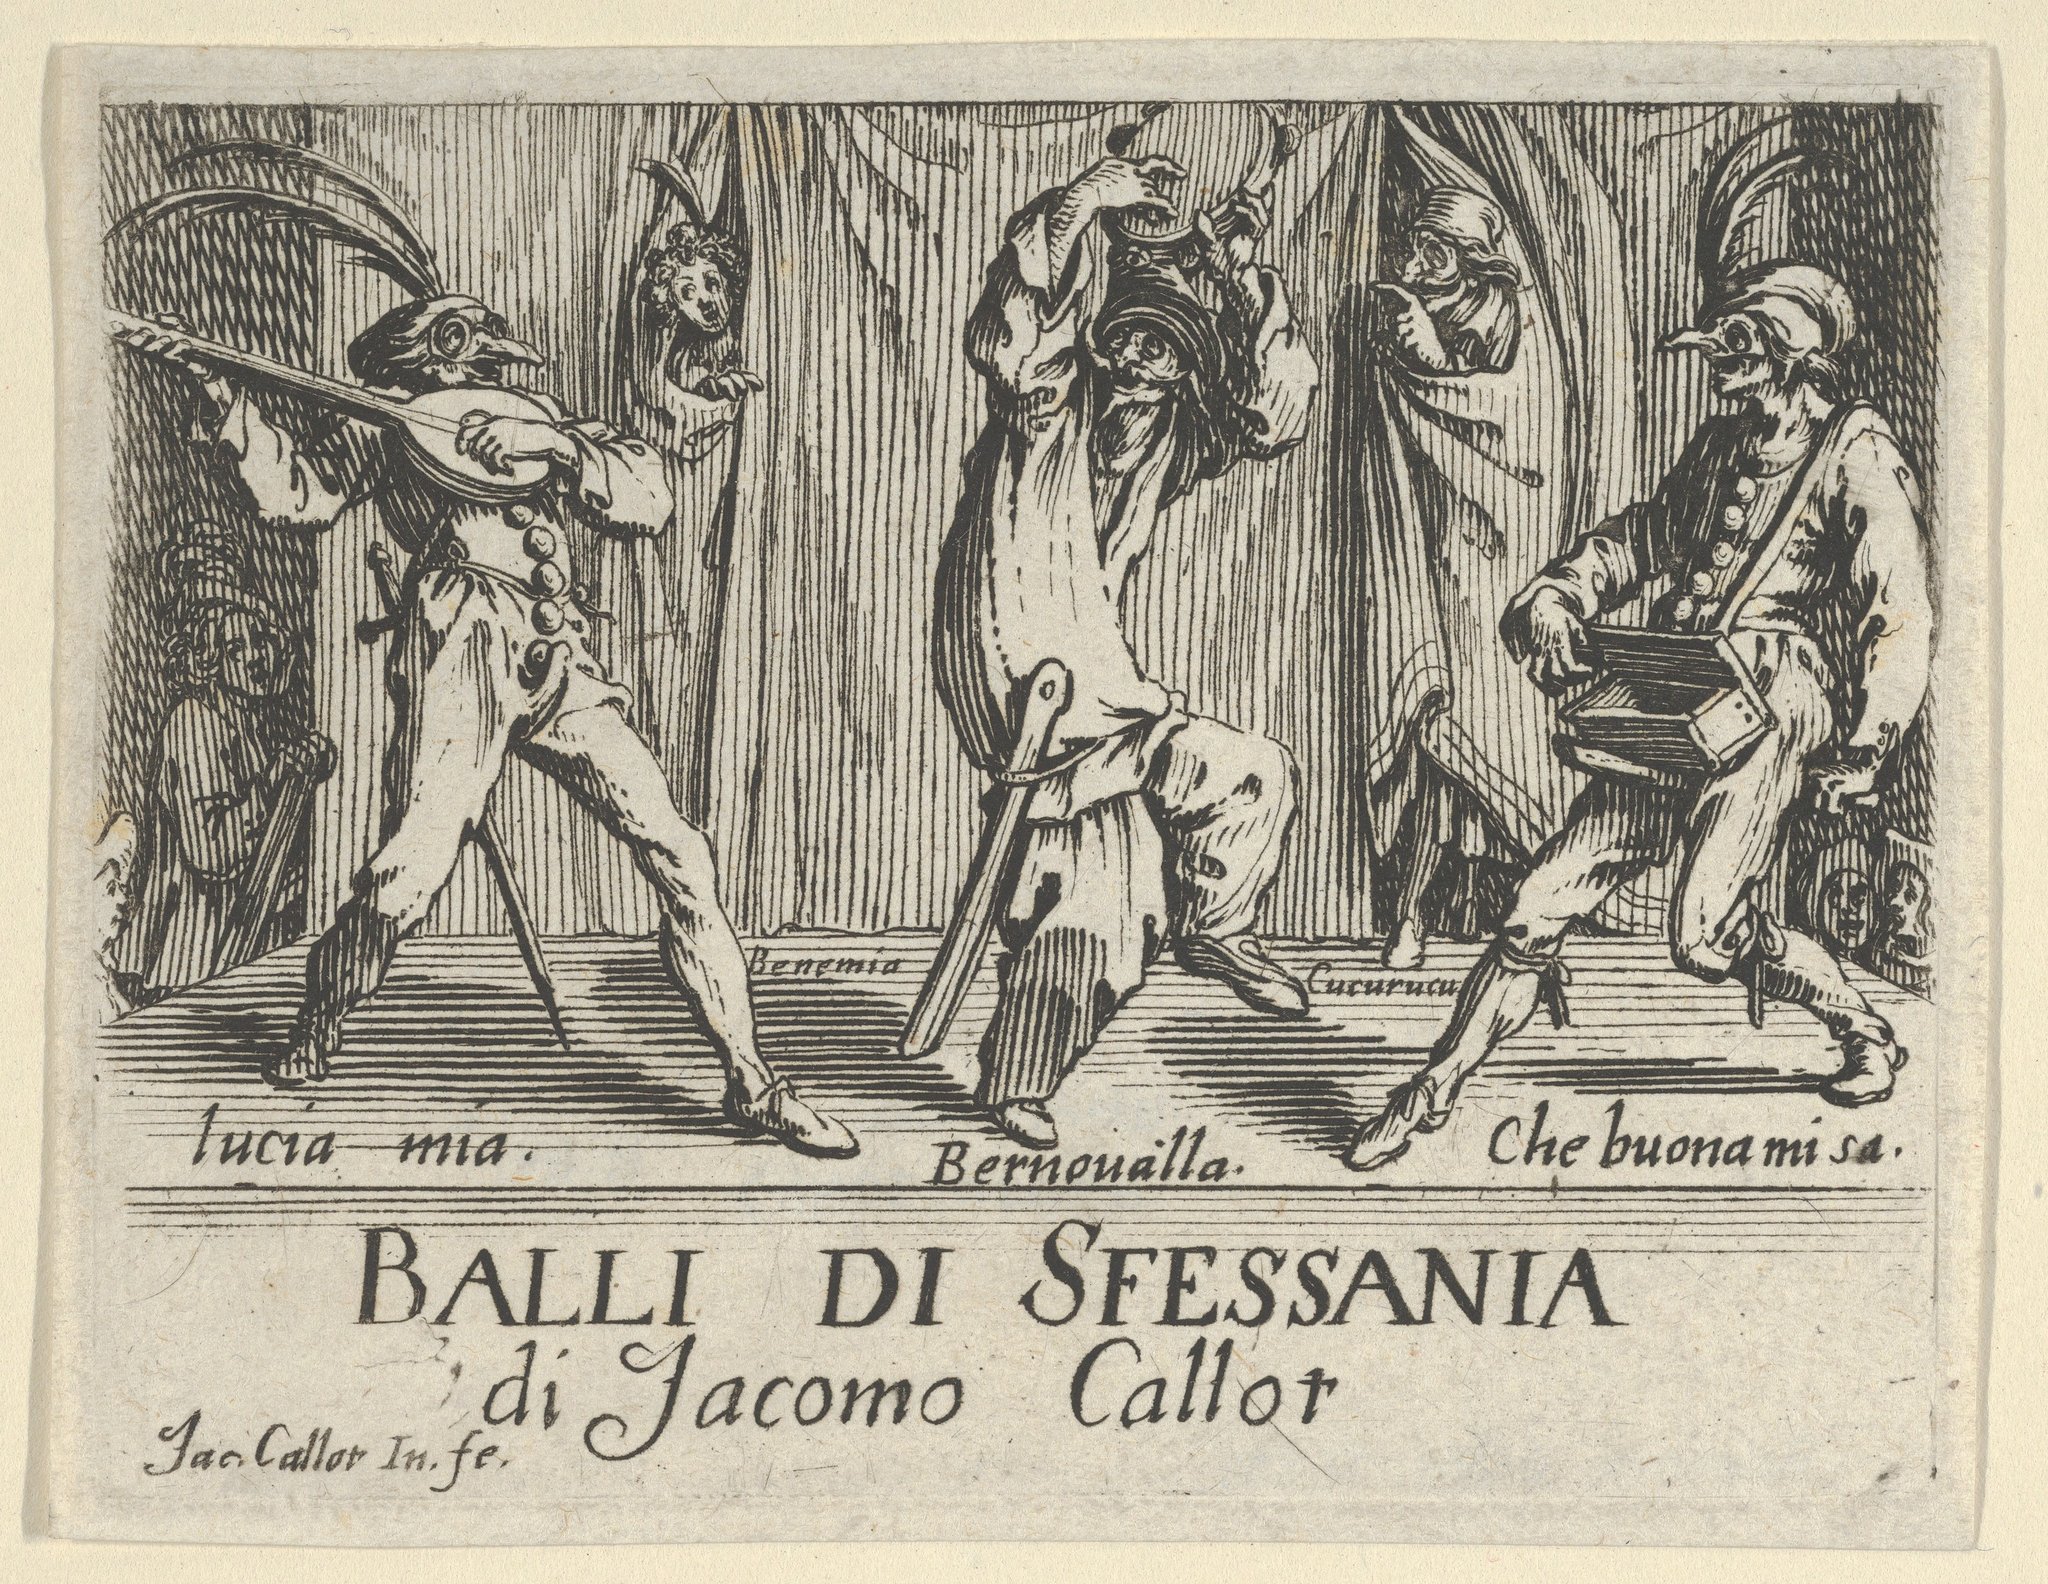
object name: print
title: Frontispiece, from "Balli di Sfessania"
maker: jacques callot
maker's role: artist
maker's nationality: french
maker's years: 1592-1635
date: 1622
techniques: etching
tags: musical instruments,satire